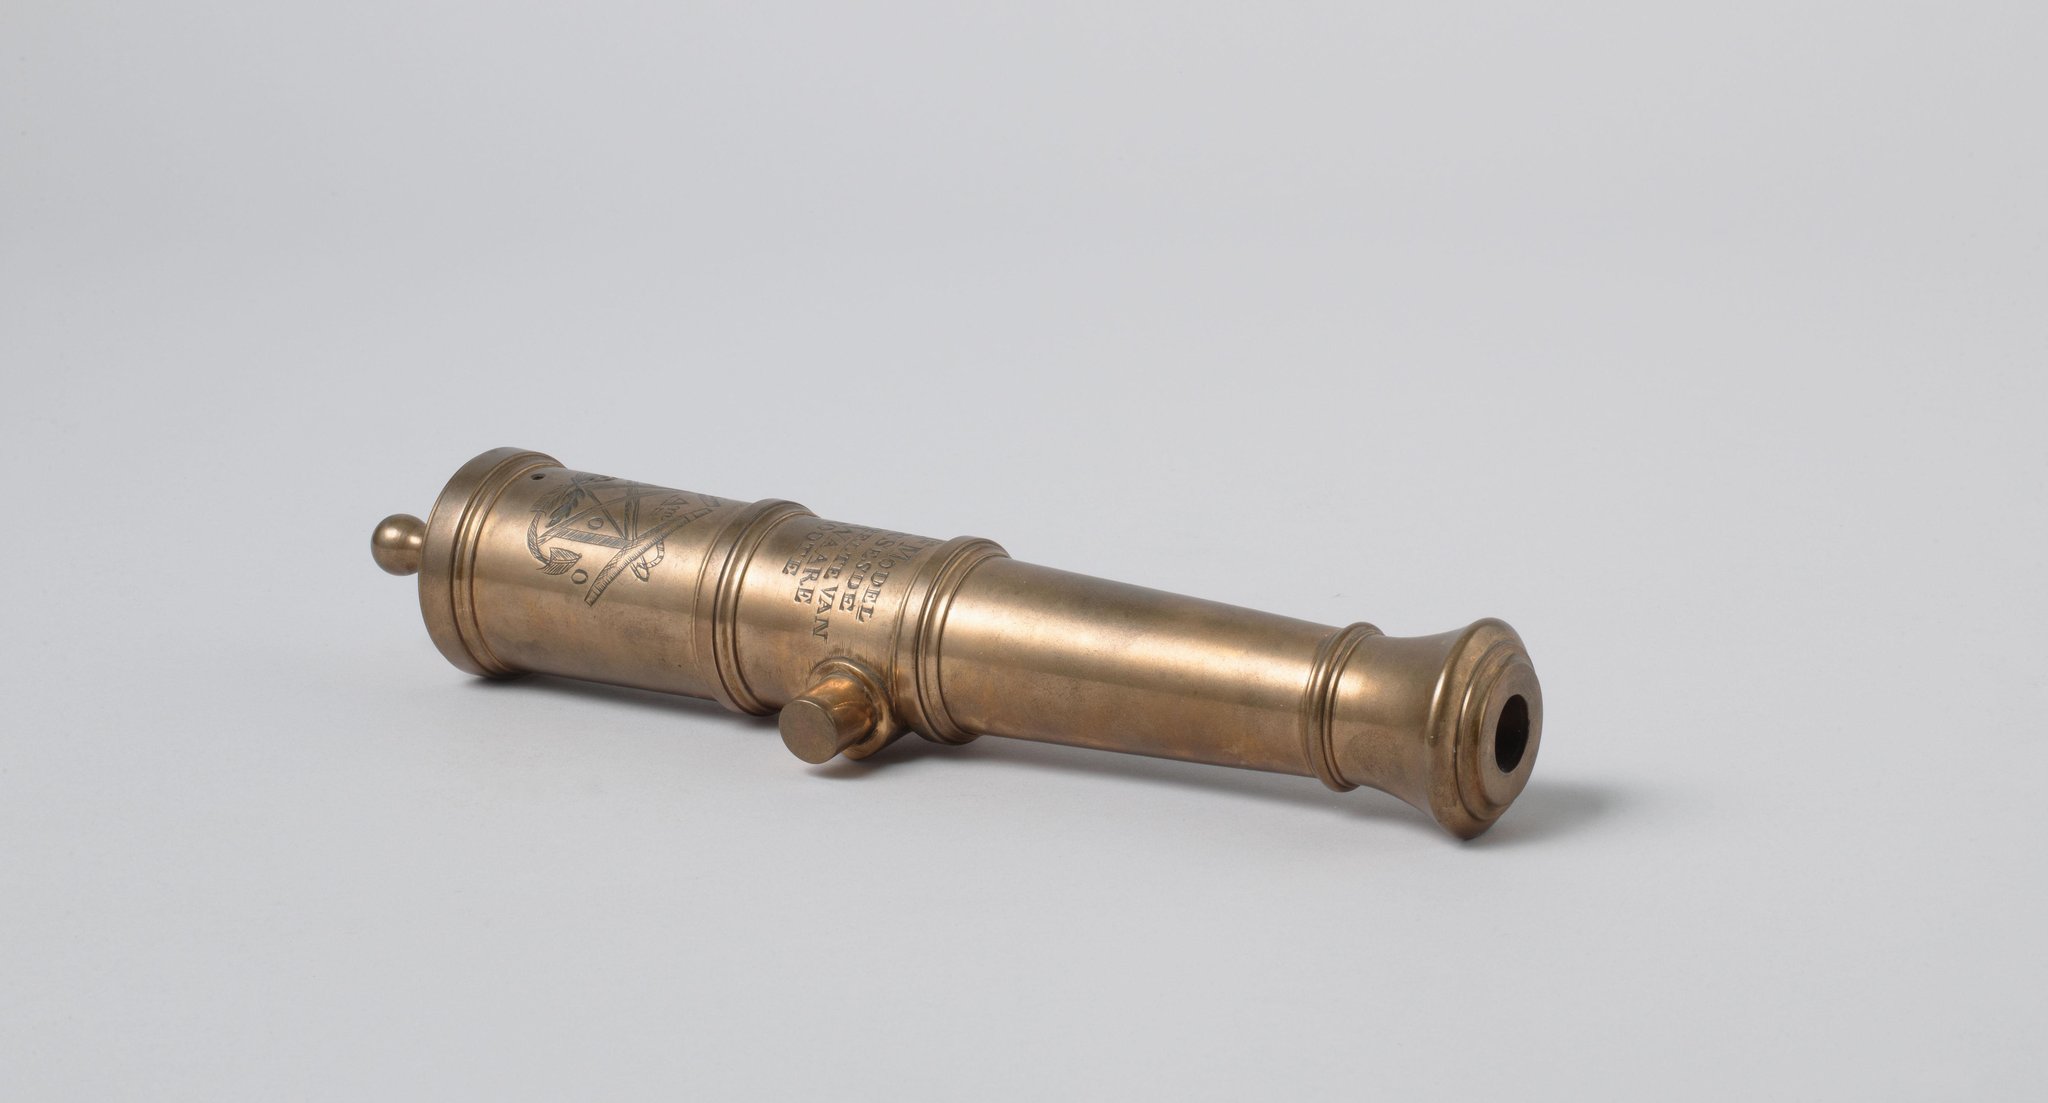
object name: demonstration model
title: Model of a 6-Pounder Gun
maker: Anonymous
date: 1800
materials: bronze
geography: rotterdam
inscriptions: inscription, on the barrel: ‘6 lbDR MODEL / EEN SESDE / GEDEELTE VAN / DE WAARE / GROOTE’, monogram, on the barrel: ‘Am 1800 M’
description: Model van een kanon van 6 pond, incompleet: het rolpaard ontbreekt. De 30,5 cm lange loop heeft een kaliber van 15,8 mm. Op de loop zijn de inscripties gegraveerd, samen met twee gekruiste ankers en palmtakken. Schaal 1:6 (schaal op model).